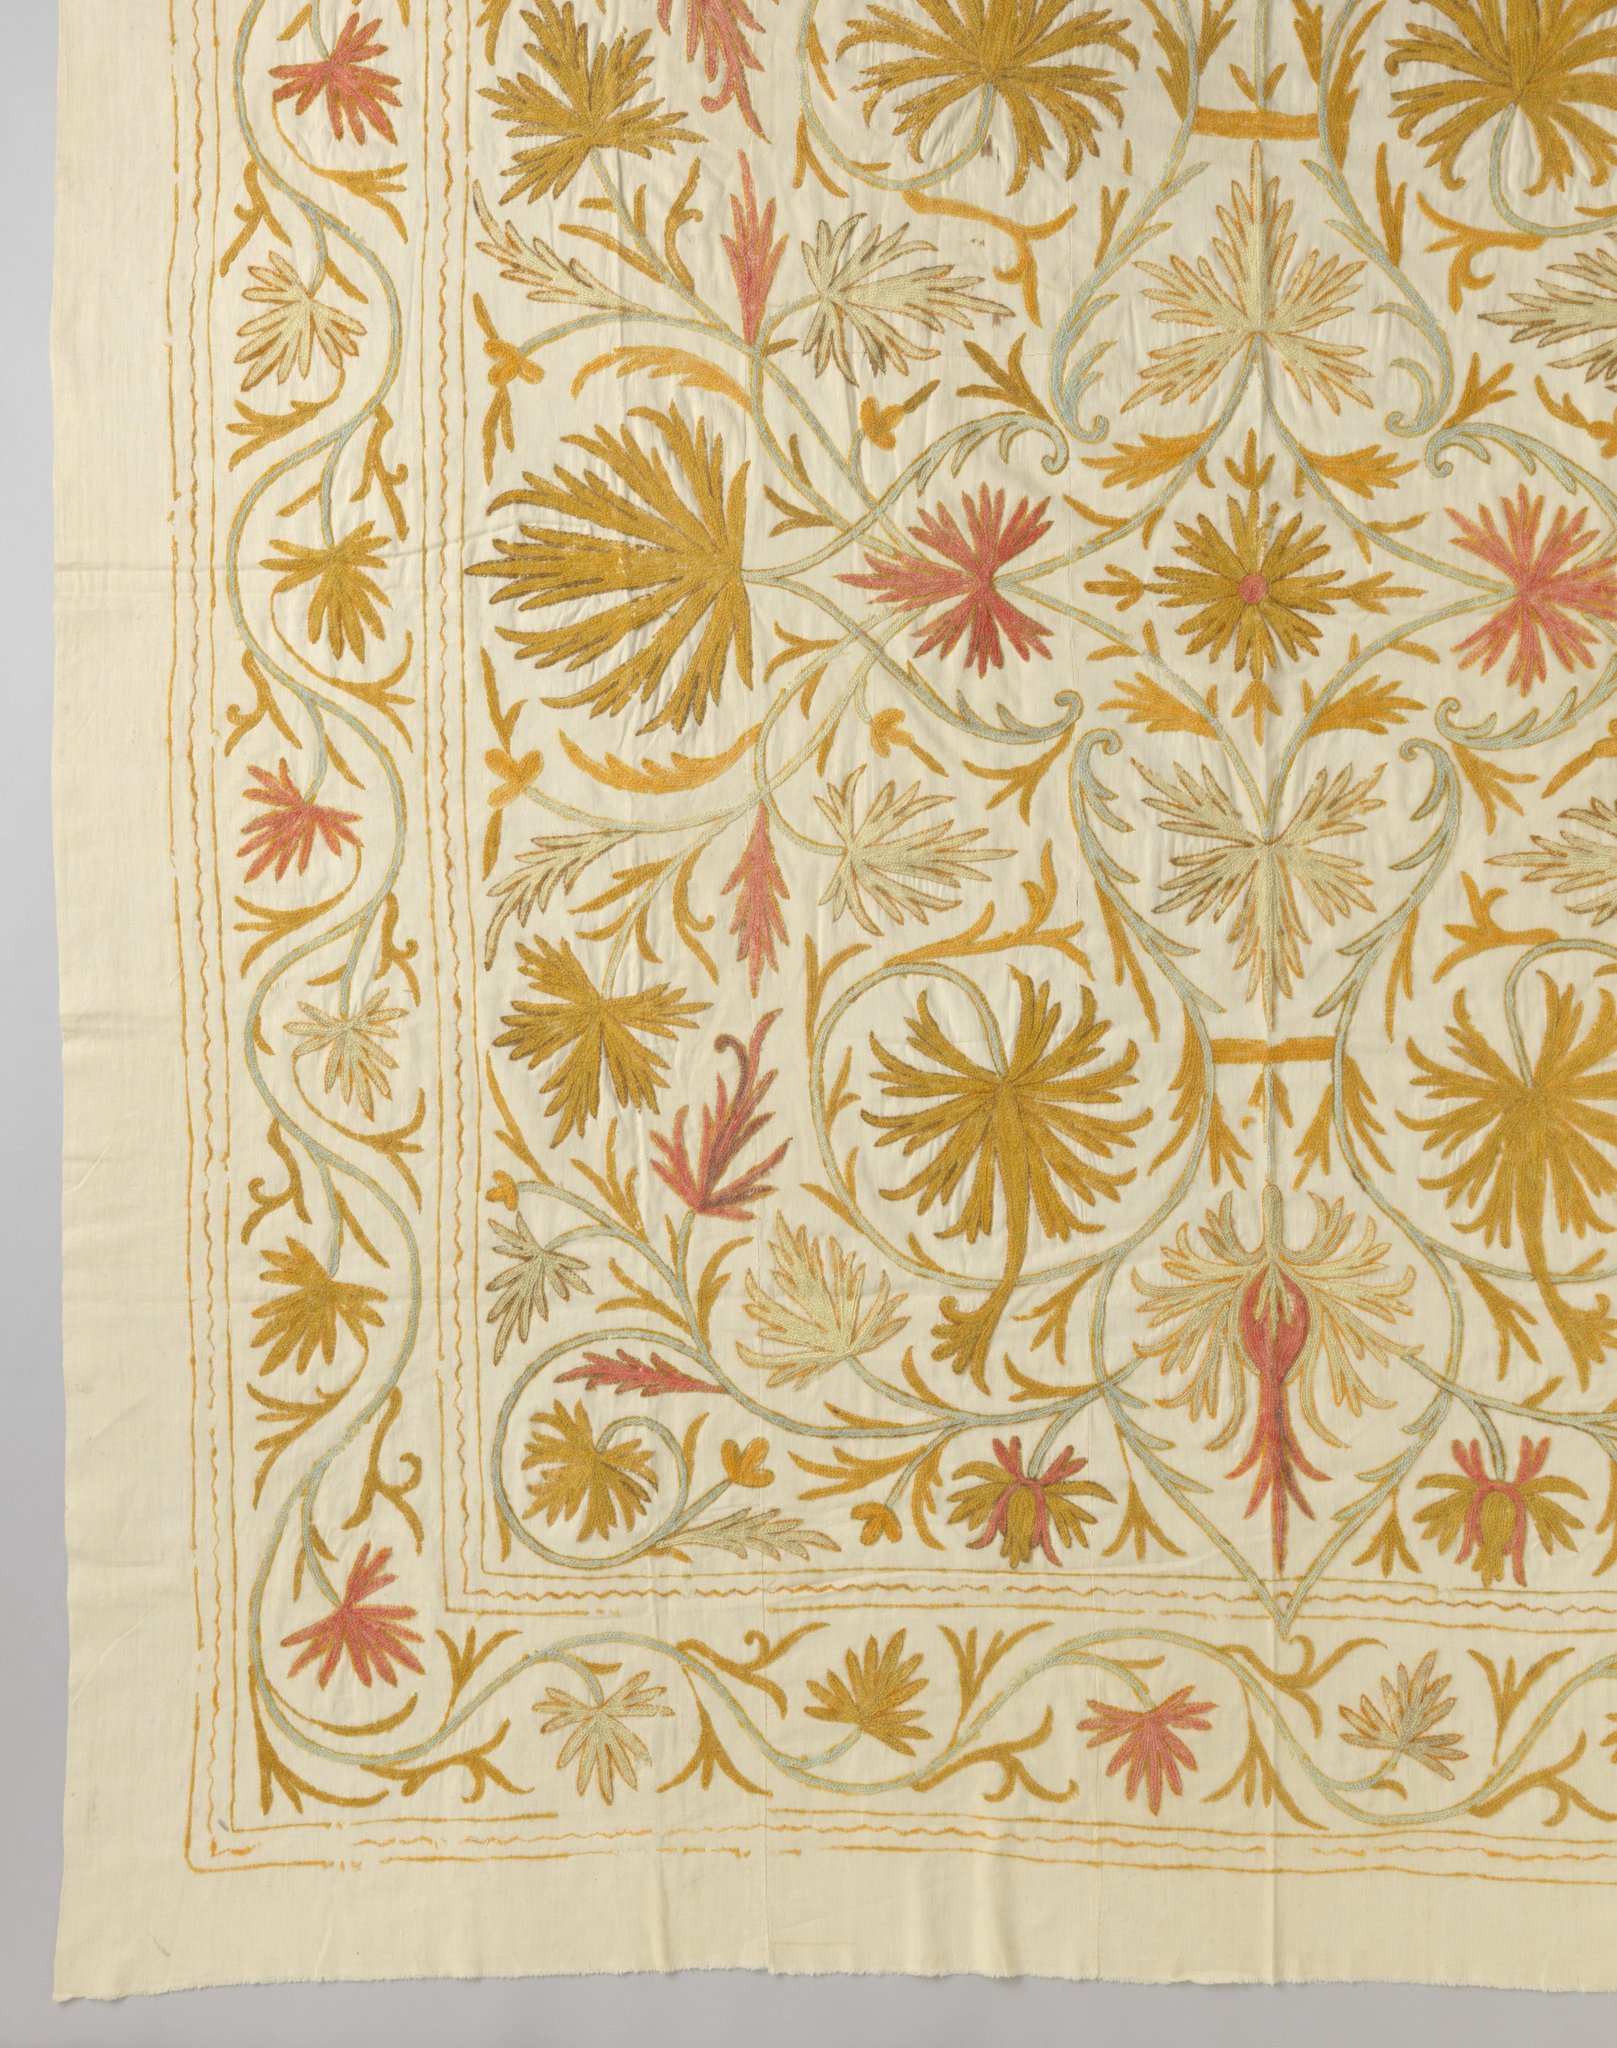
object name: textile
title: Sprei van oosterse textiel met borduurwerk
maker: Anonymous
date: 1875-1890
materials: cotton, wool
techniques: embroidered, weave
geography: eastern europe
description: Veelkleurig geborduurd sprei, waarvan het midden en de randen versierd zijn met takken met bladeren en bloemen. Opmerking: Zelfkant in het weefsel opgenomen.